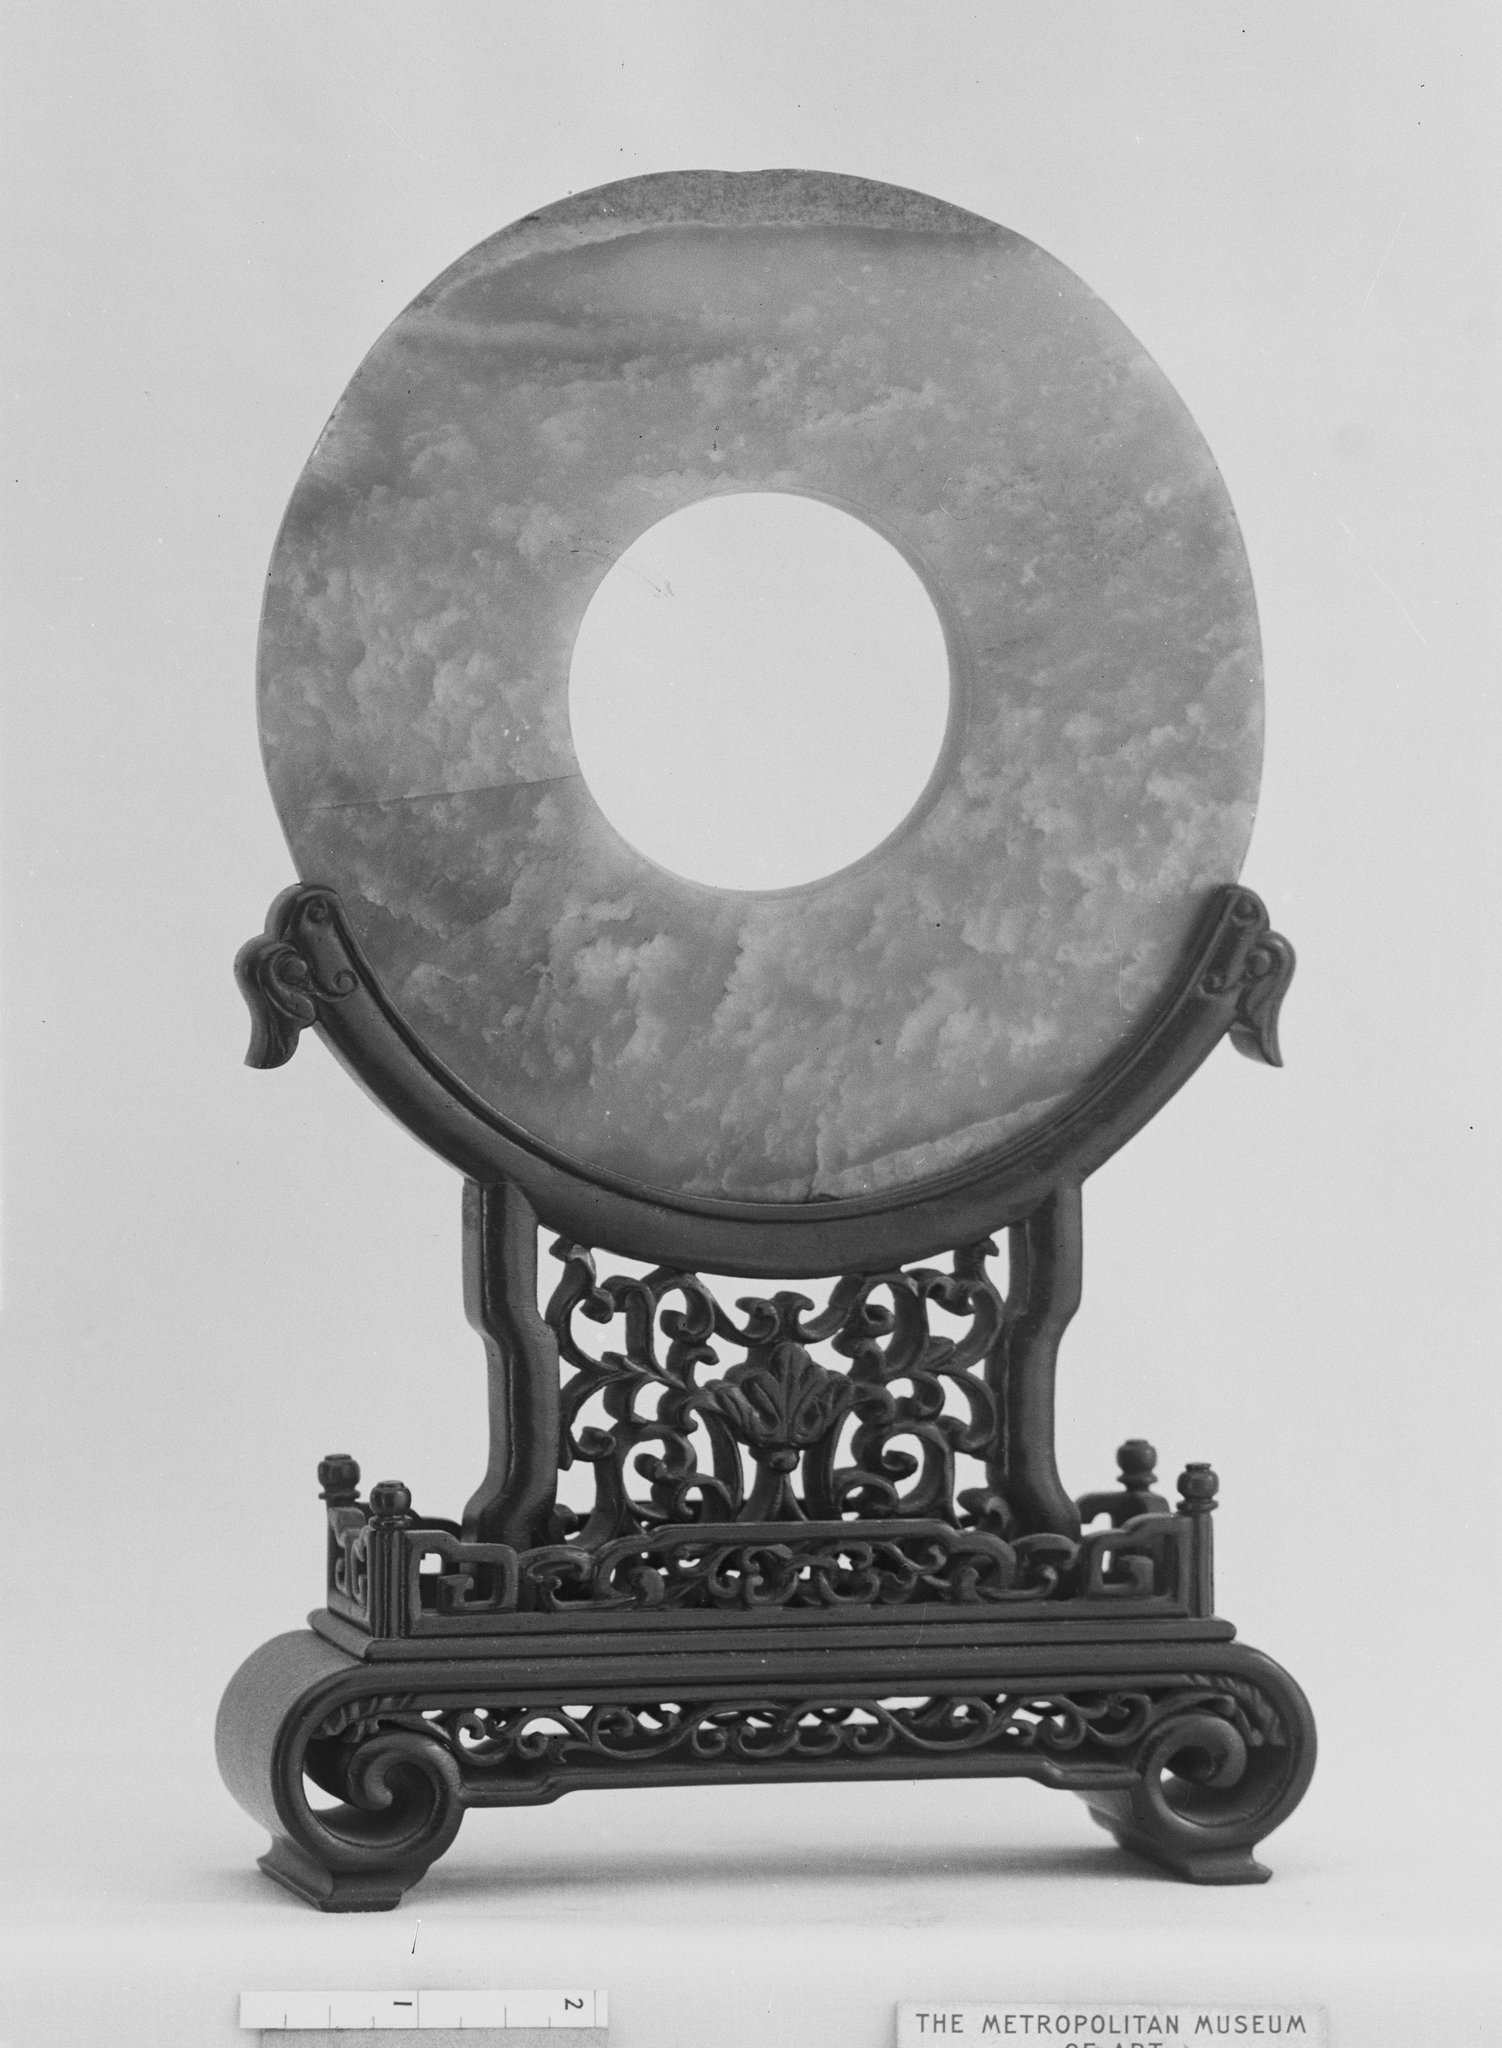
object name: religious ritual object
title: Ritual Object (Bi)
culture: chinese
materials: jade